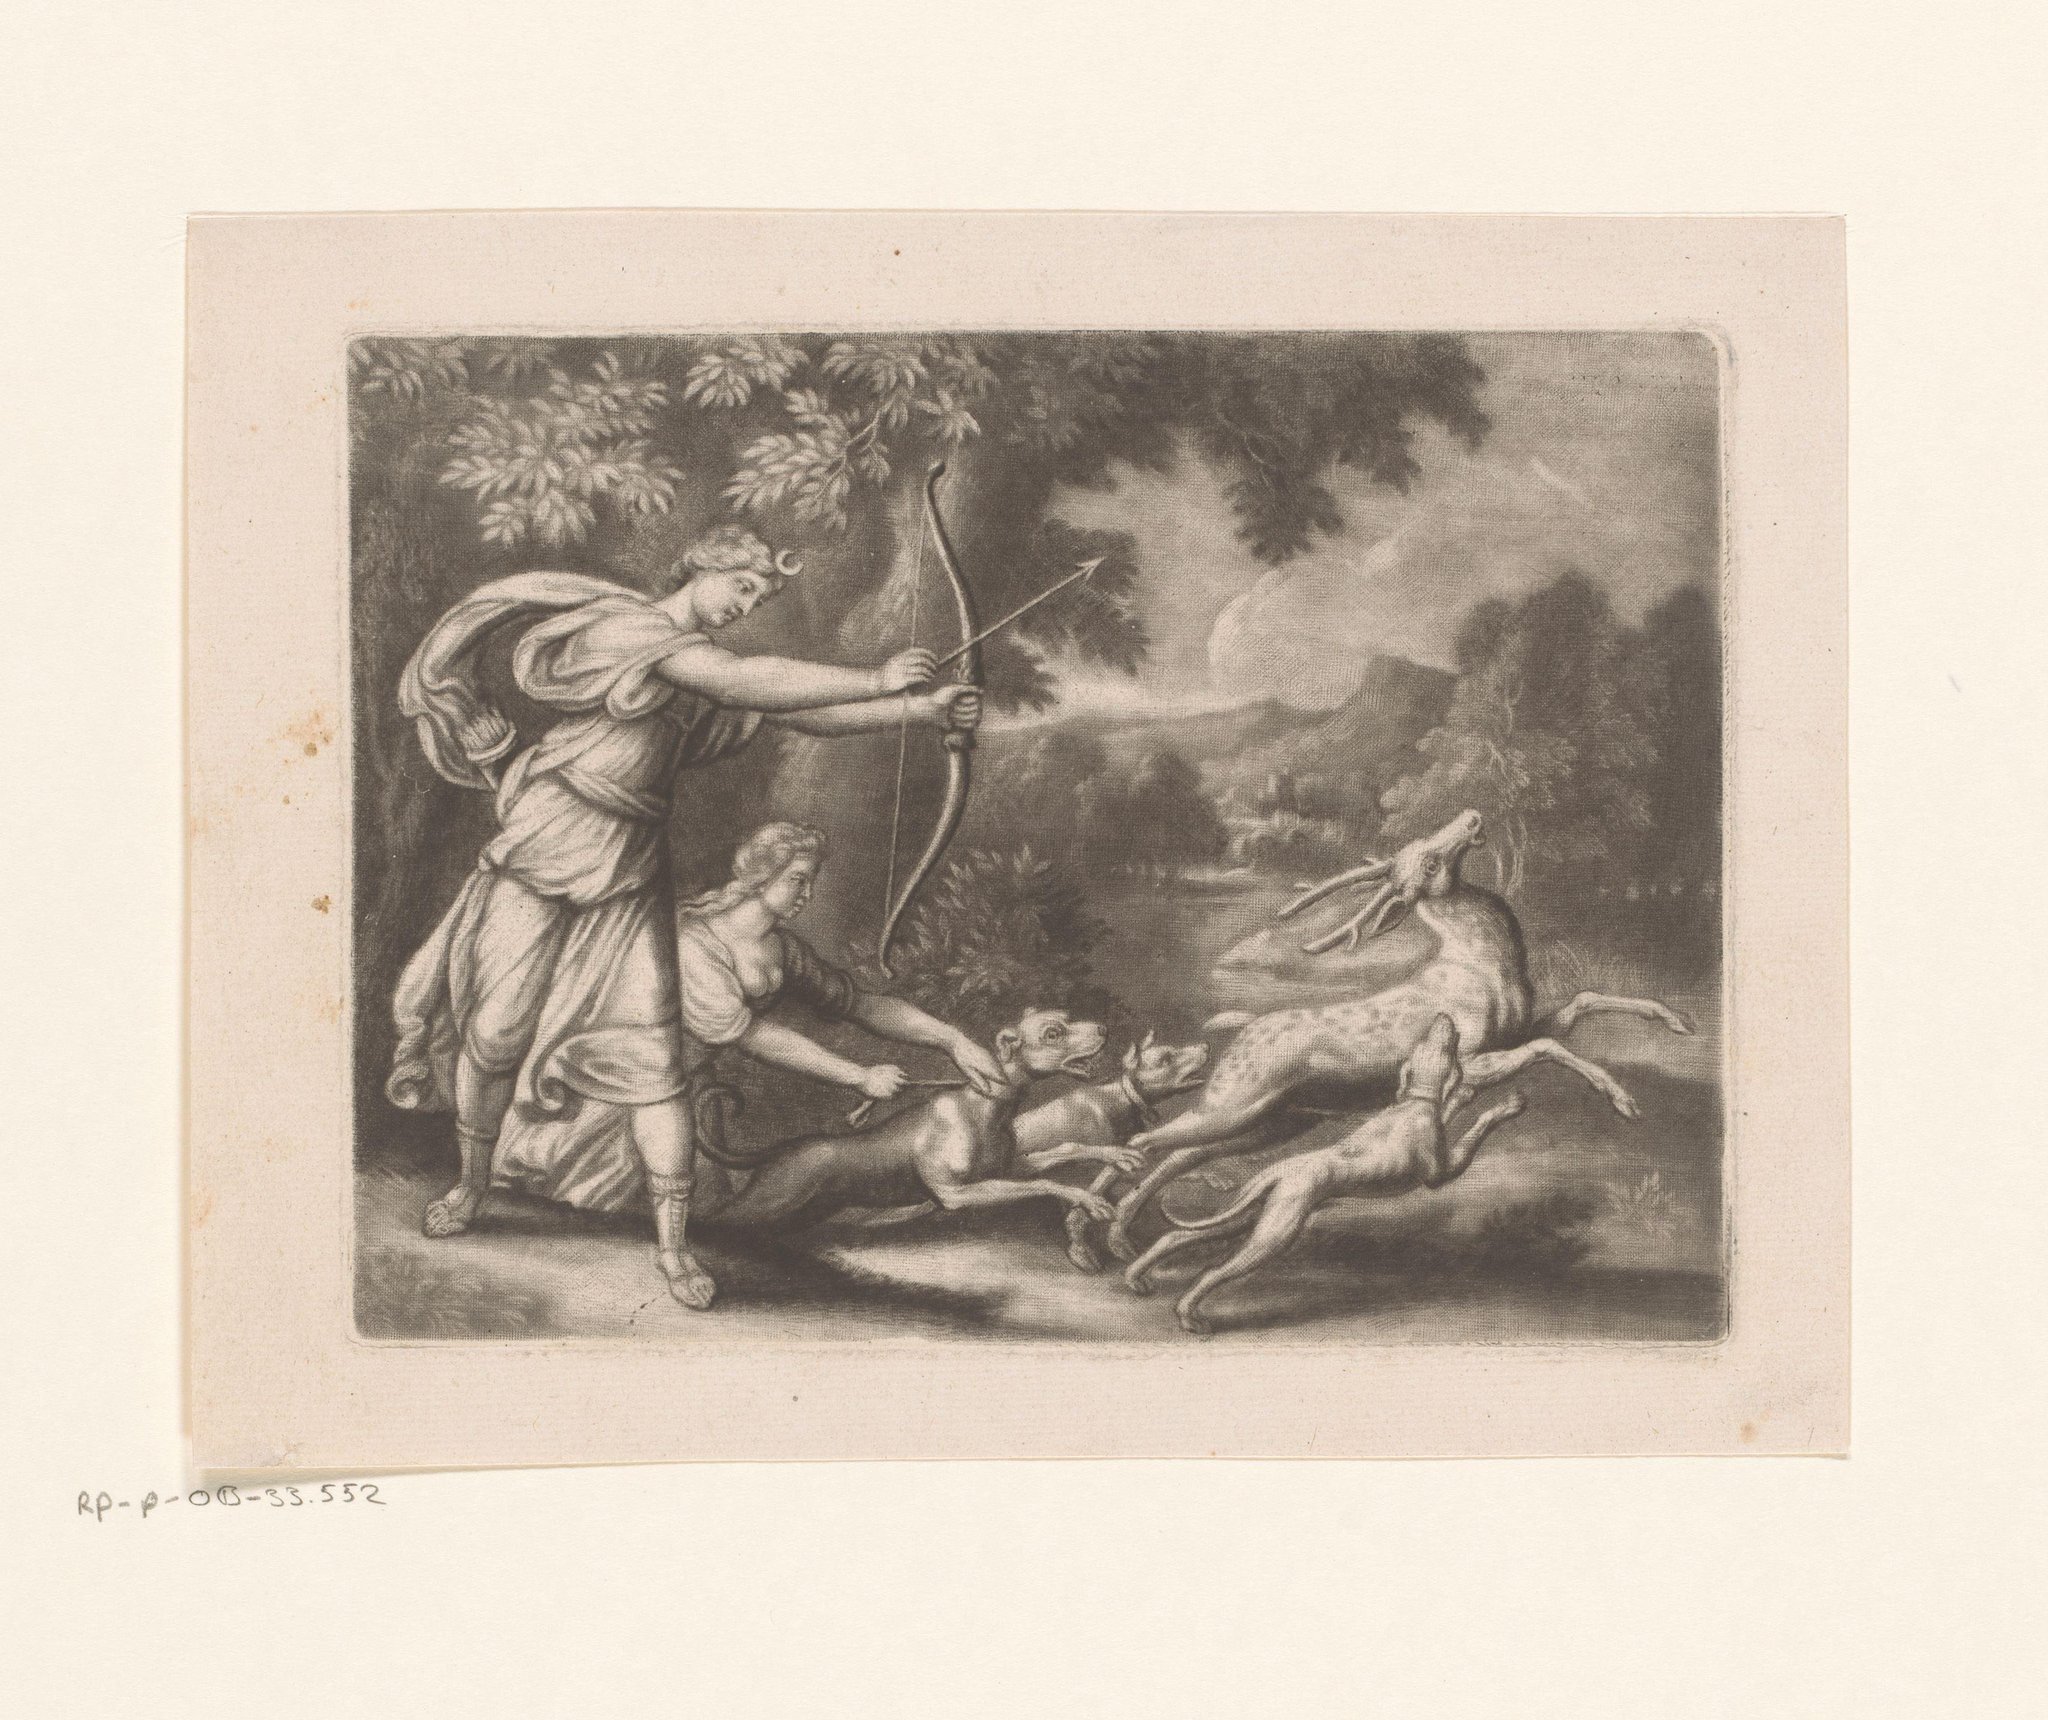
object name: print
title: Diana op hertenjacht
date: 1680-1730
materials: paper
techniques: mezzotint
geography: london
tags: diana hunting, stag-hunting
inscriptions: collector's mark: Lugt 240